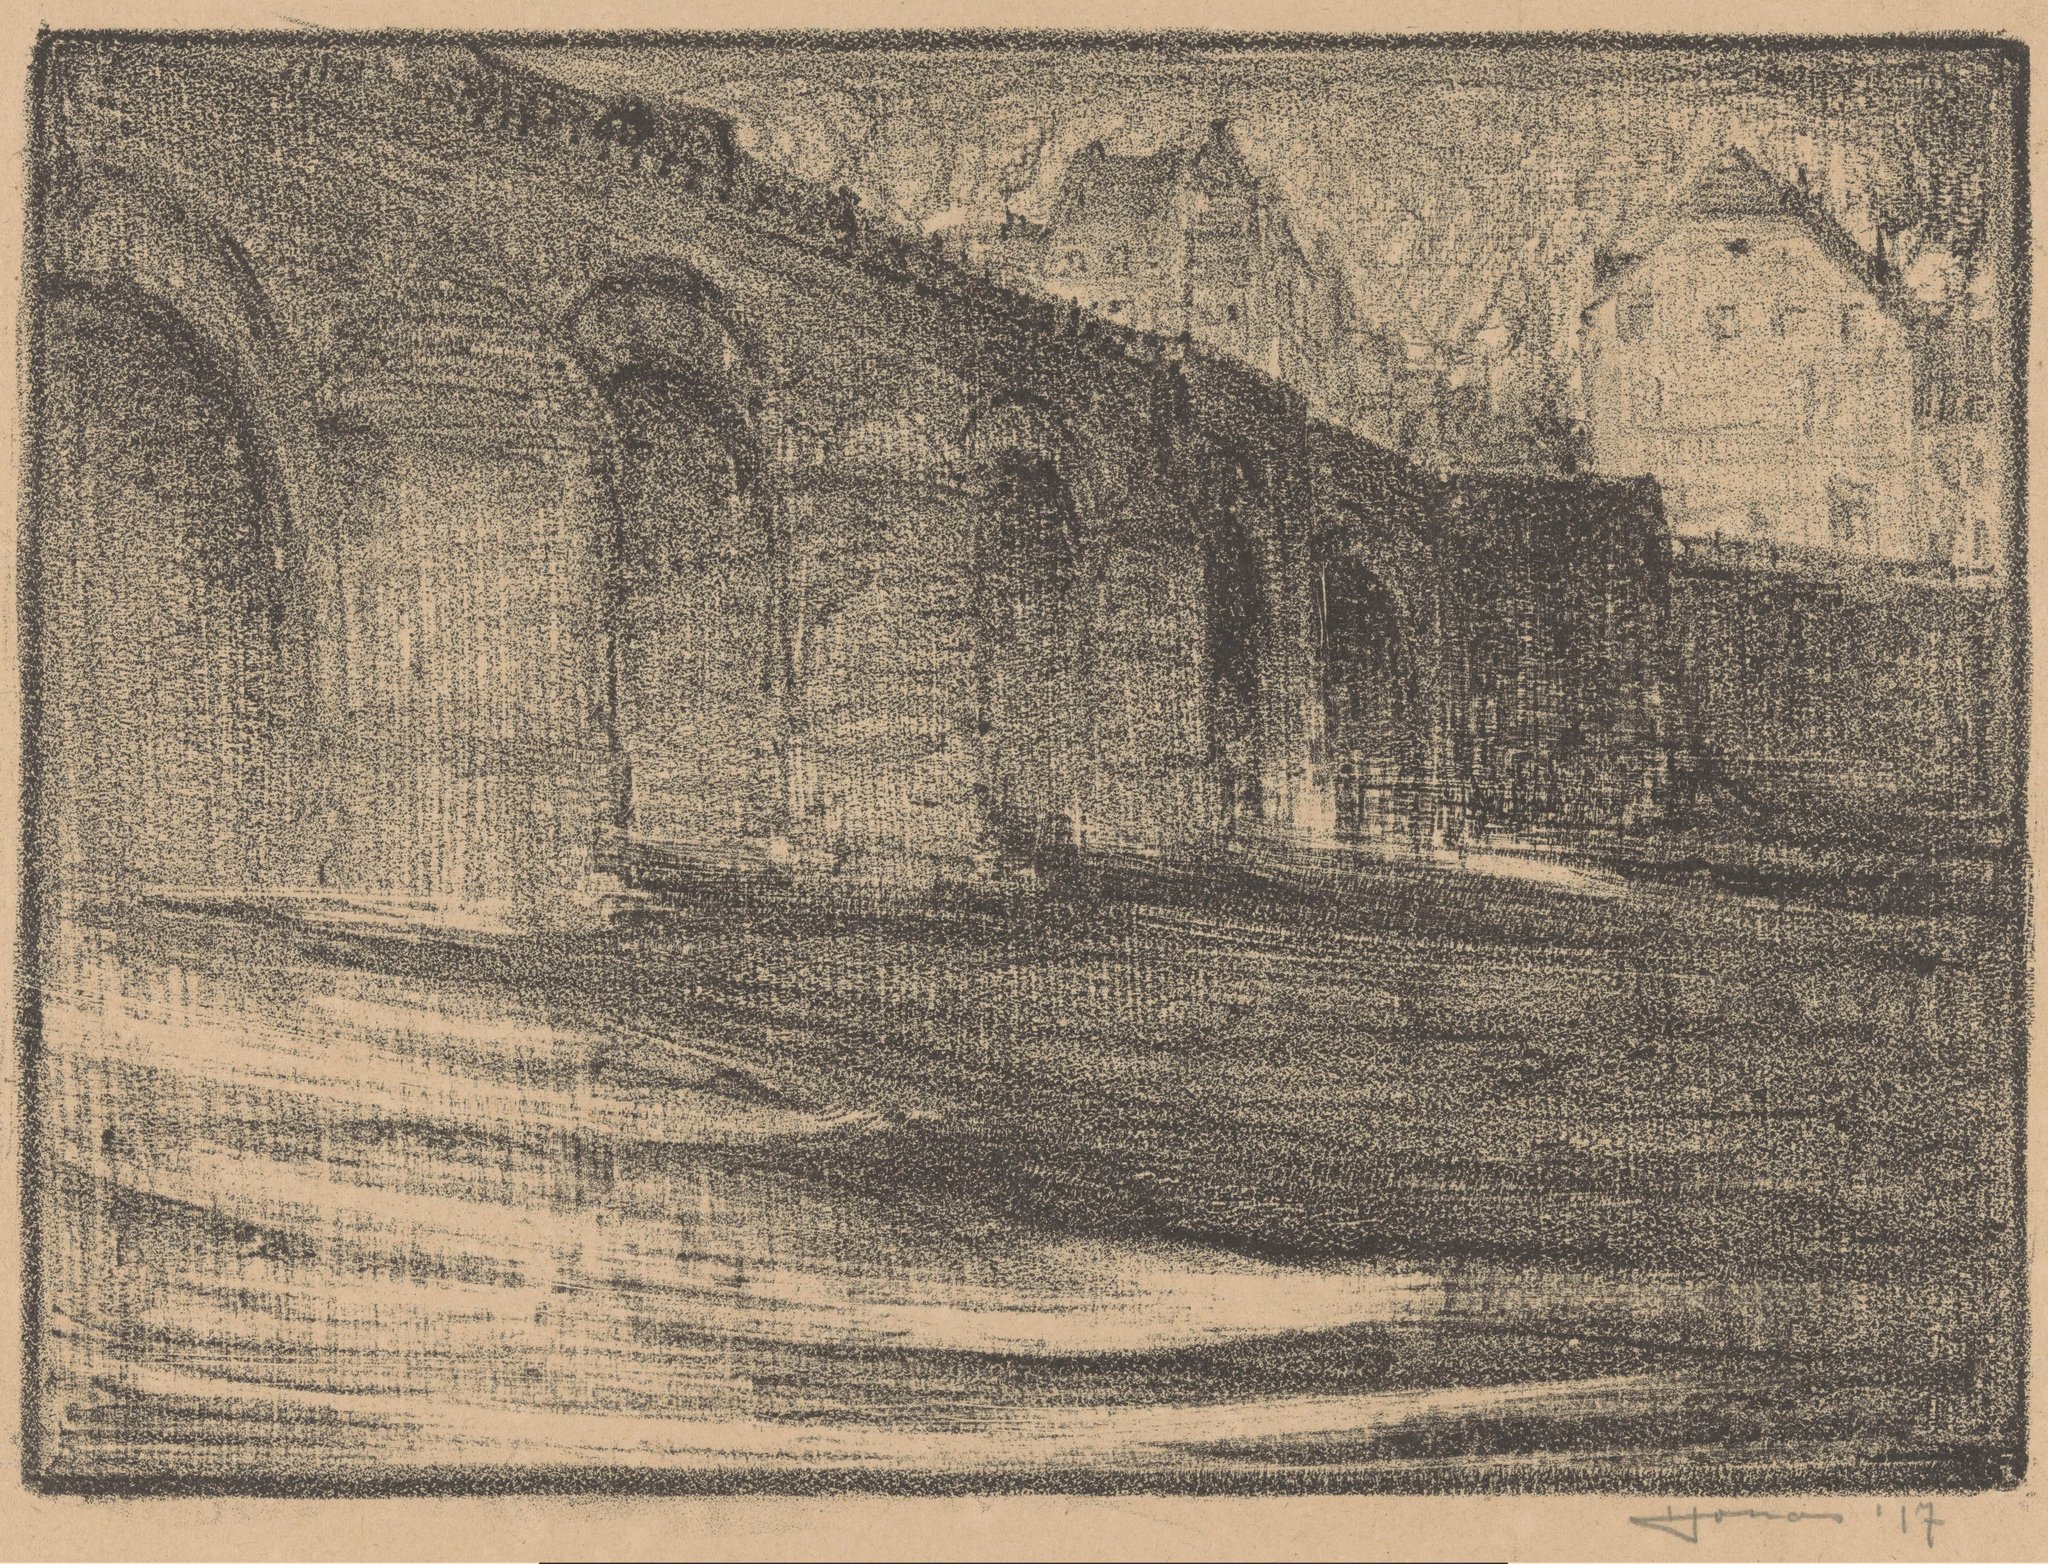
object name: print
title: Sint Servaasbrug over de Maas in Maastricht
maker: henri jonas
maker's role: draughtsman, print maker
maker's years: 1878-1944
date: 1917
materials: paper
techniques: lithograph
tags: bridge in city across river, canal, etc.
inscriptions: collector's mark: Lugt 2228